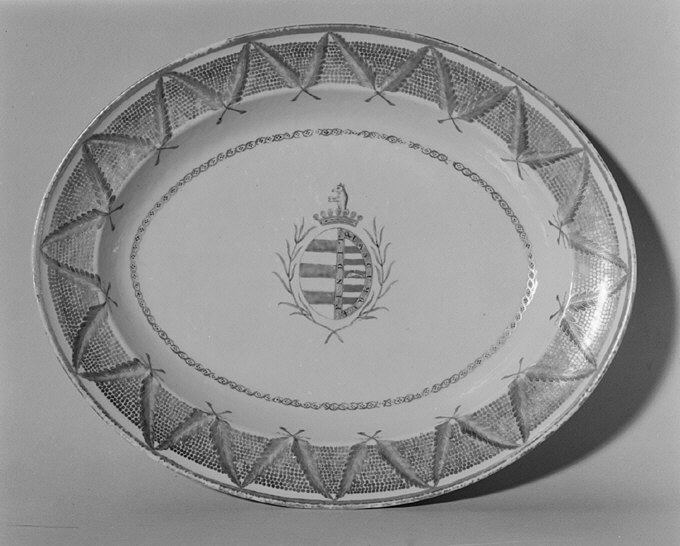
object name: serving dish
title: Serving dish (part of a service)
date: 1810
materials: hard paste porcelain